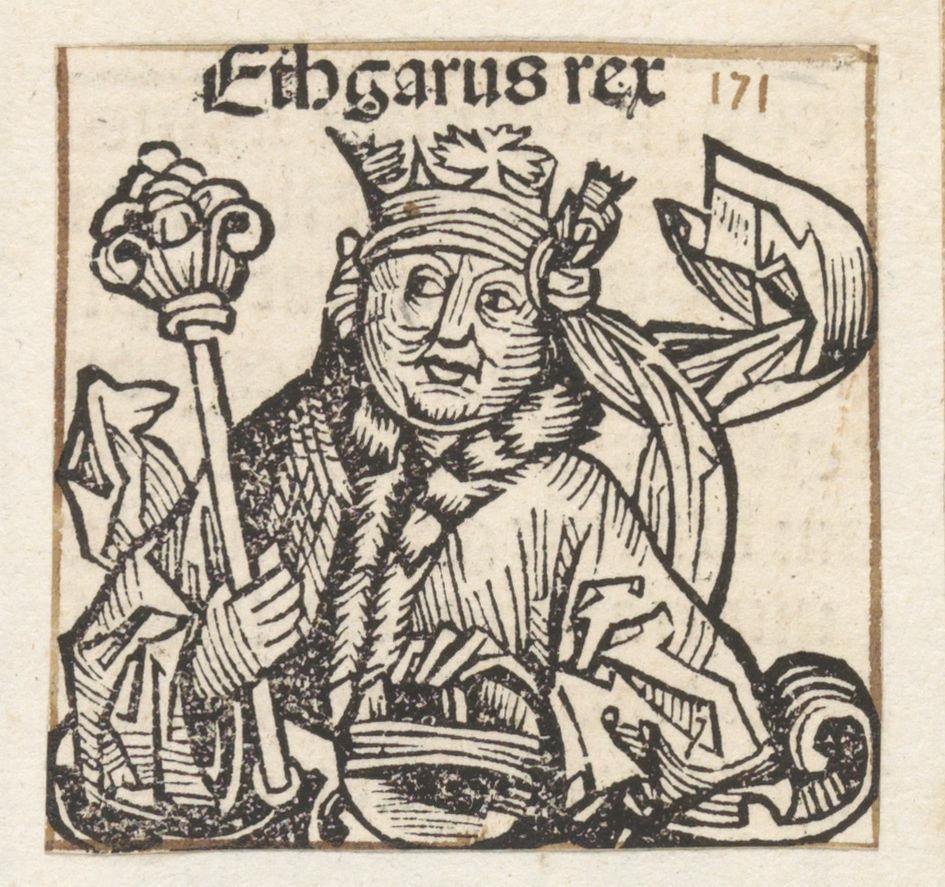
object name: album leaf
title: Liber Chronicarum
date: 1493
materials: paper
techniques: letterpress printing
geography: nuremberg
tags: king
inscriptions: inscription: ‘171’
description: De houtsnede wordt herhaaldelijk gebruikt als boekillustratie in de Liber Chronicarum (of Neurenbergkroniek) van Hartmann Schedel, verschenen in het Latijn en Duits in 1493. Zie de Latijnse uitgave, folio 182v.